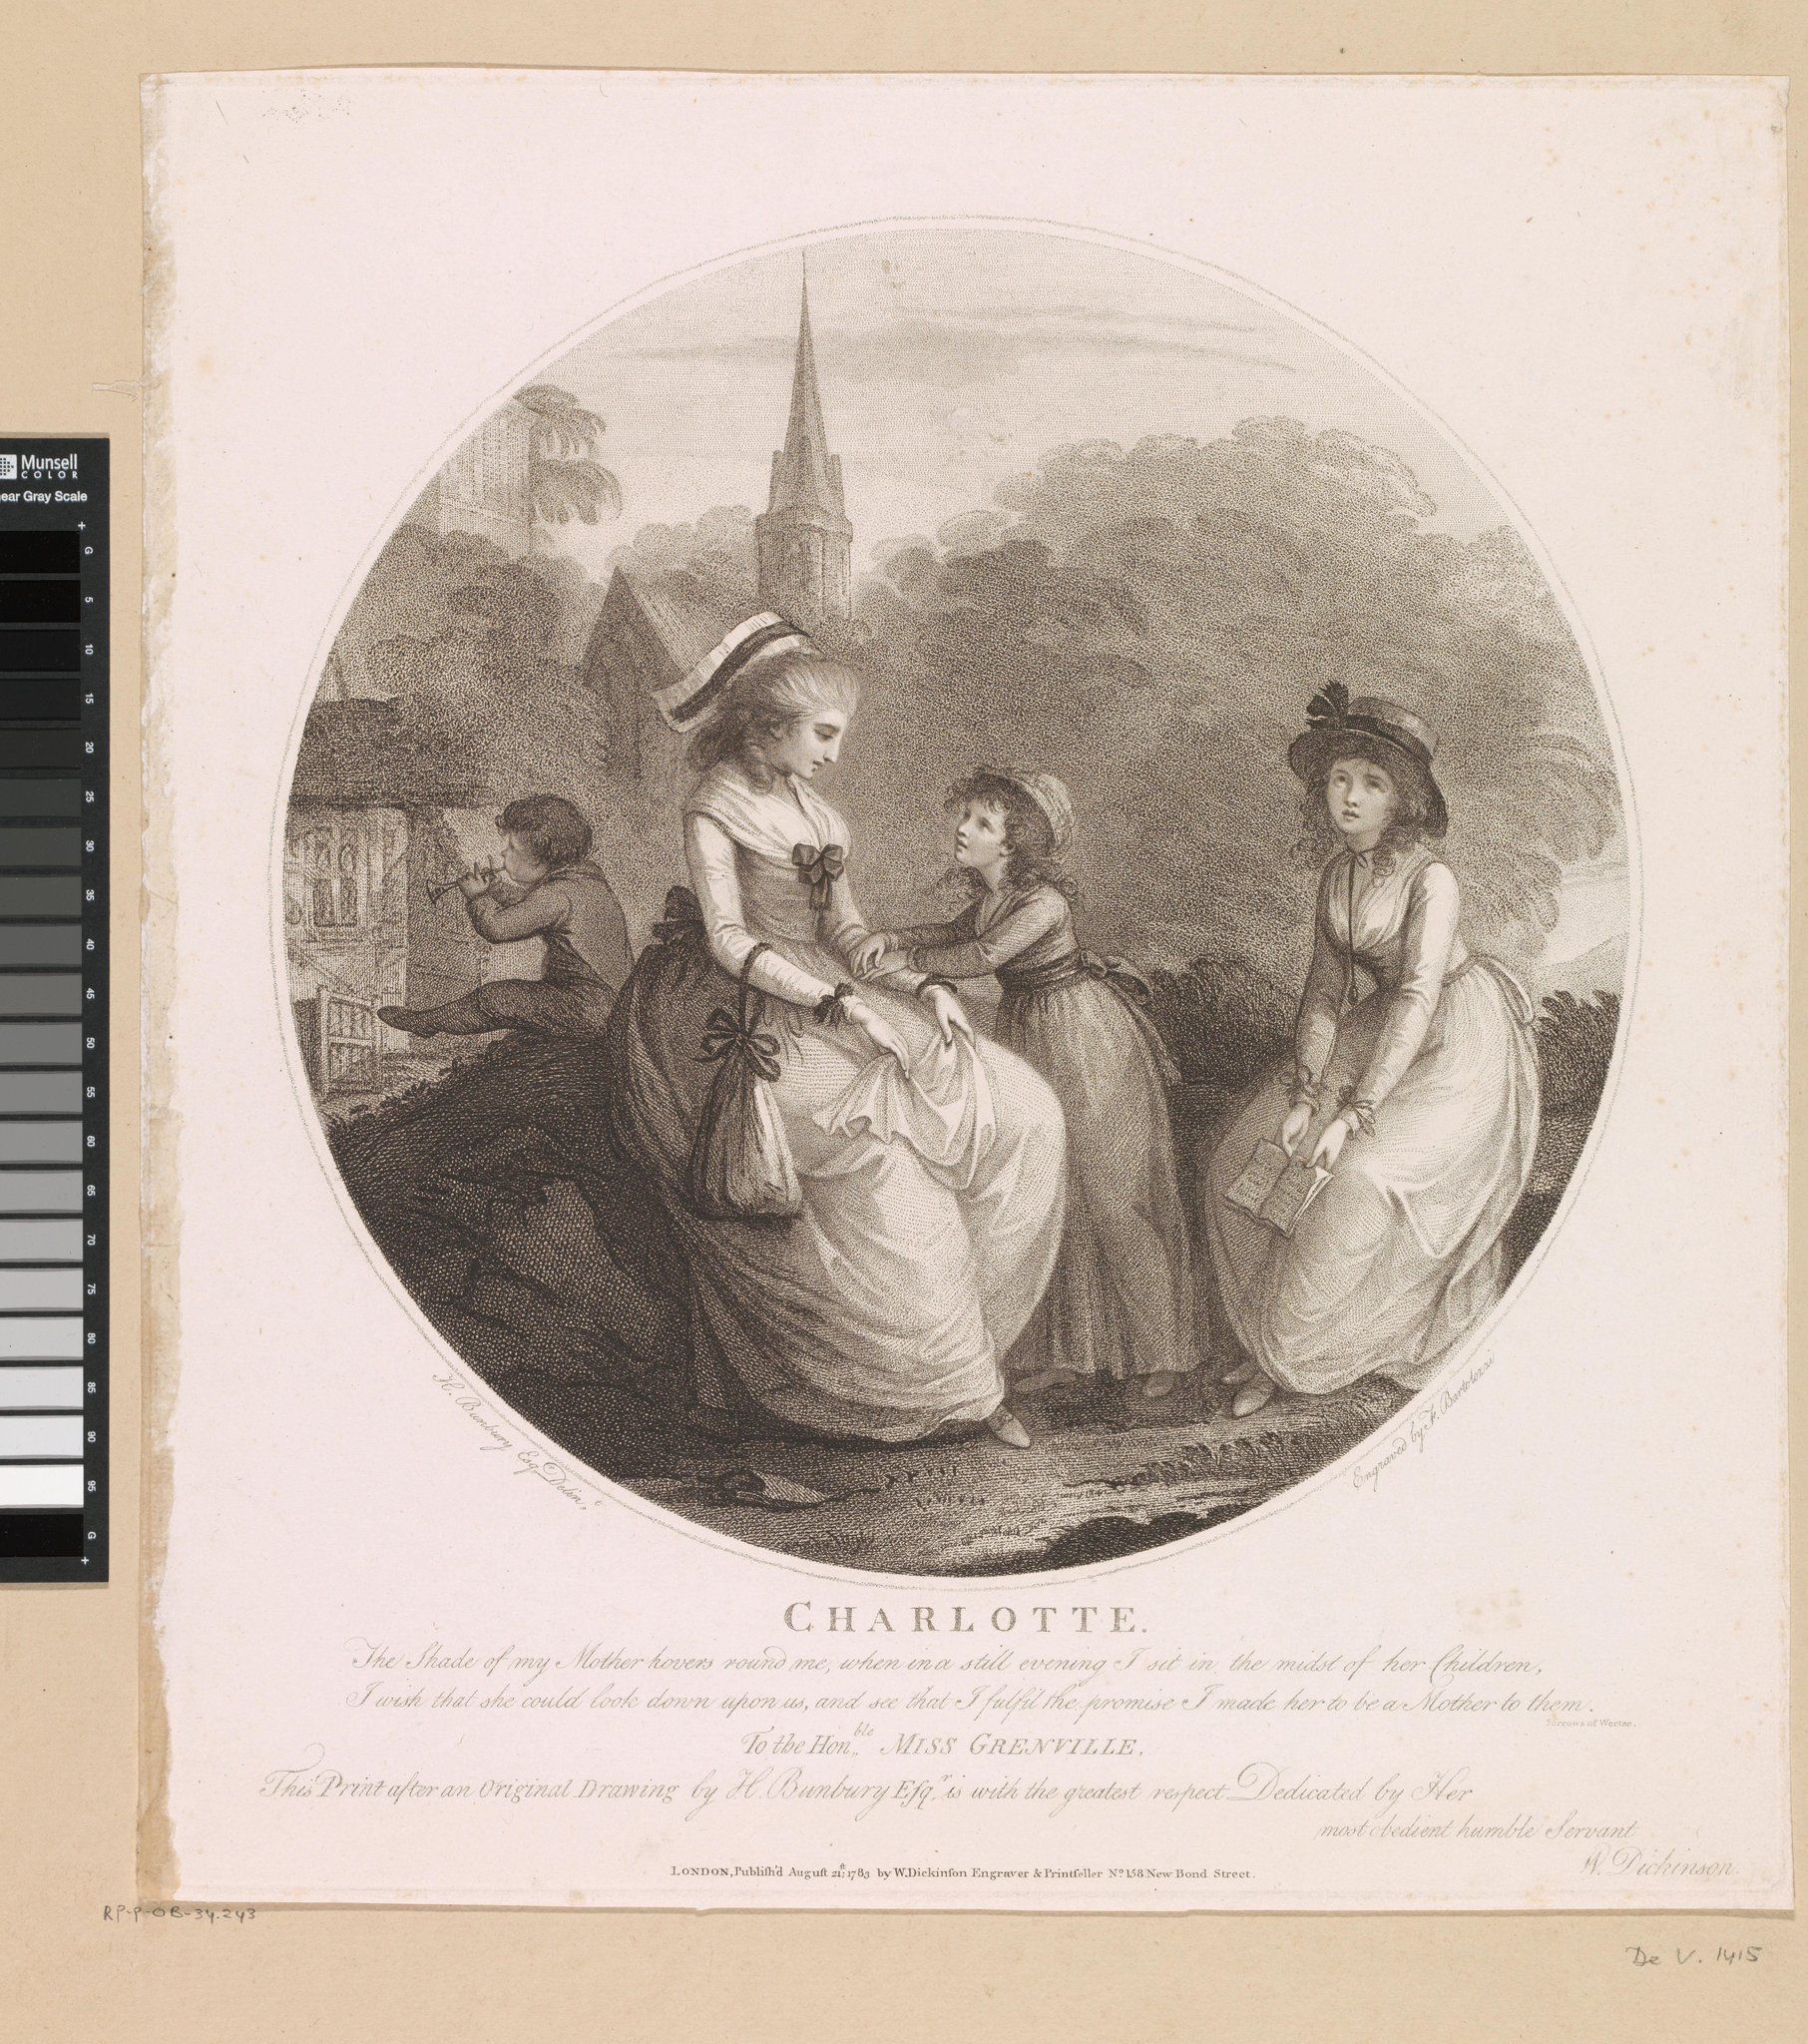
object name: print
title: Charlotte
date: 1783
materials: paper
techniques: etching, engraving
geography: london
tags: adolescent, young woman, maiden, adult woman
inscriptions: collector's mark: Lugt 2165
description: Scène uit The Sorrows of Young Werther door Goethe. Charlotte zit buiten. Een jong meisje legt haar armen op Charlotte. Rechts zit een meisje met een boek, links zit een jongen met een fluit.